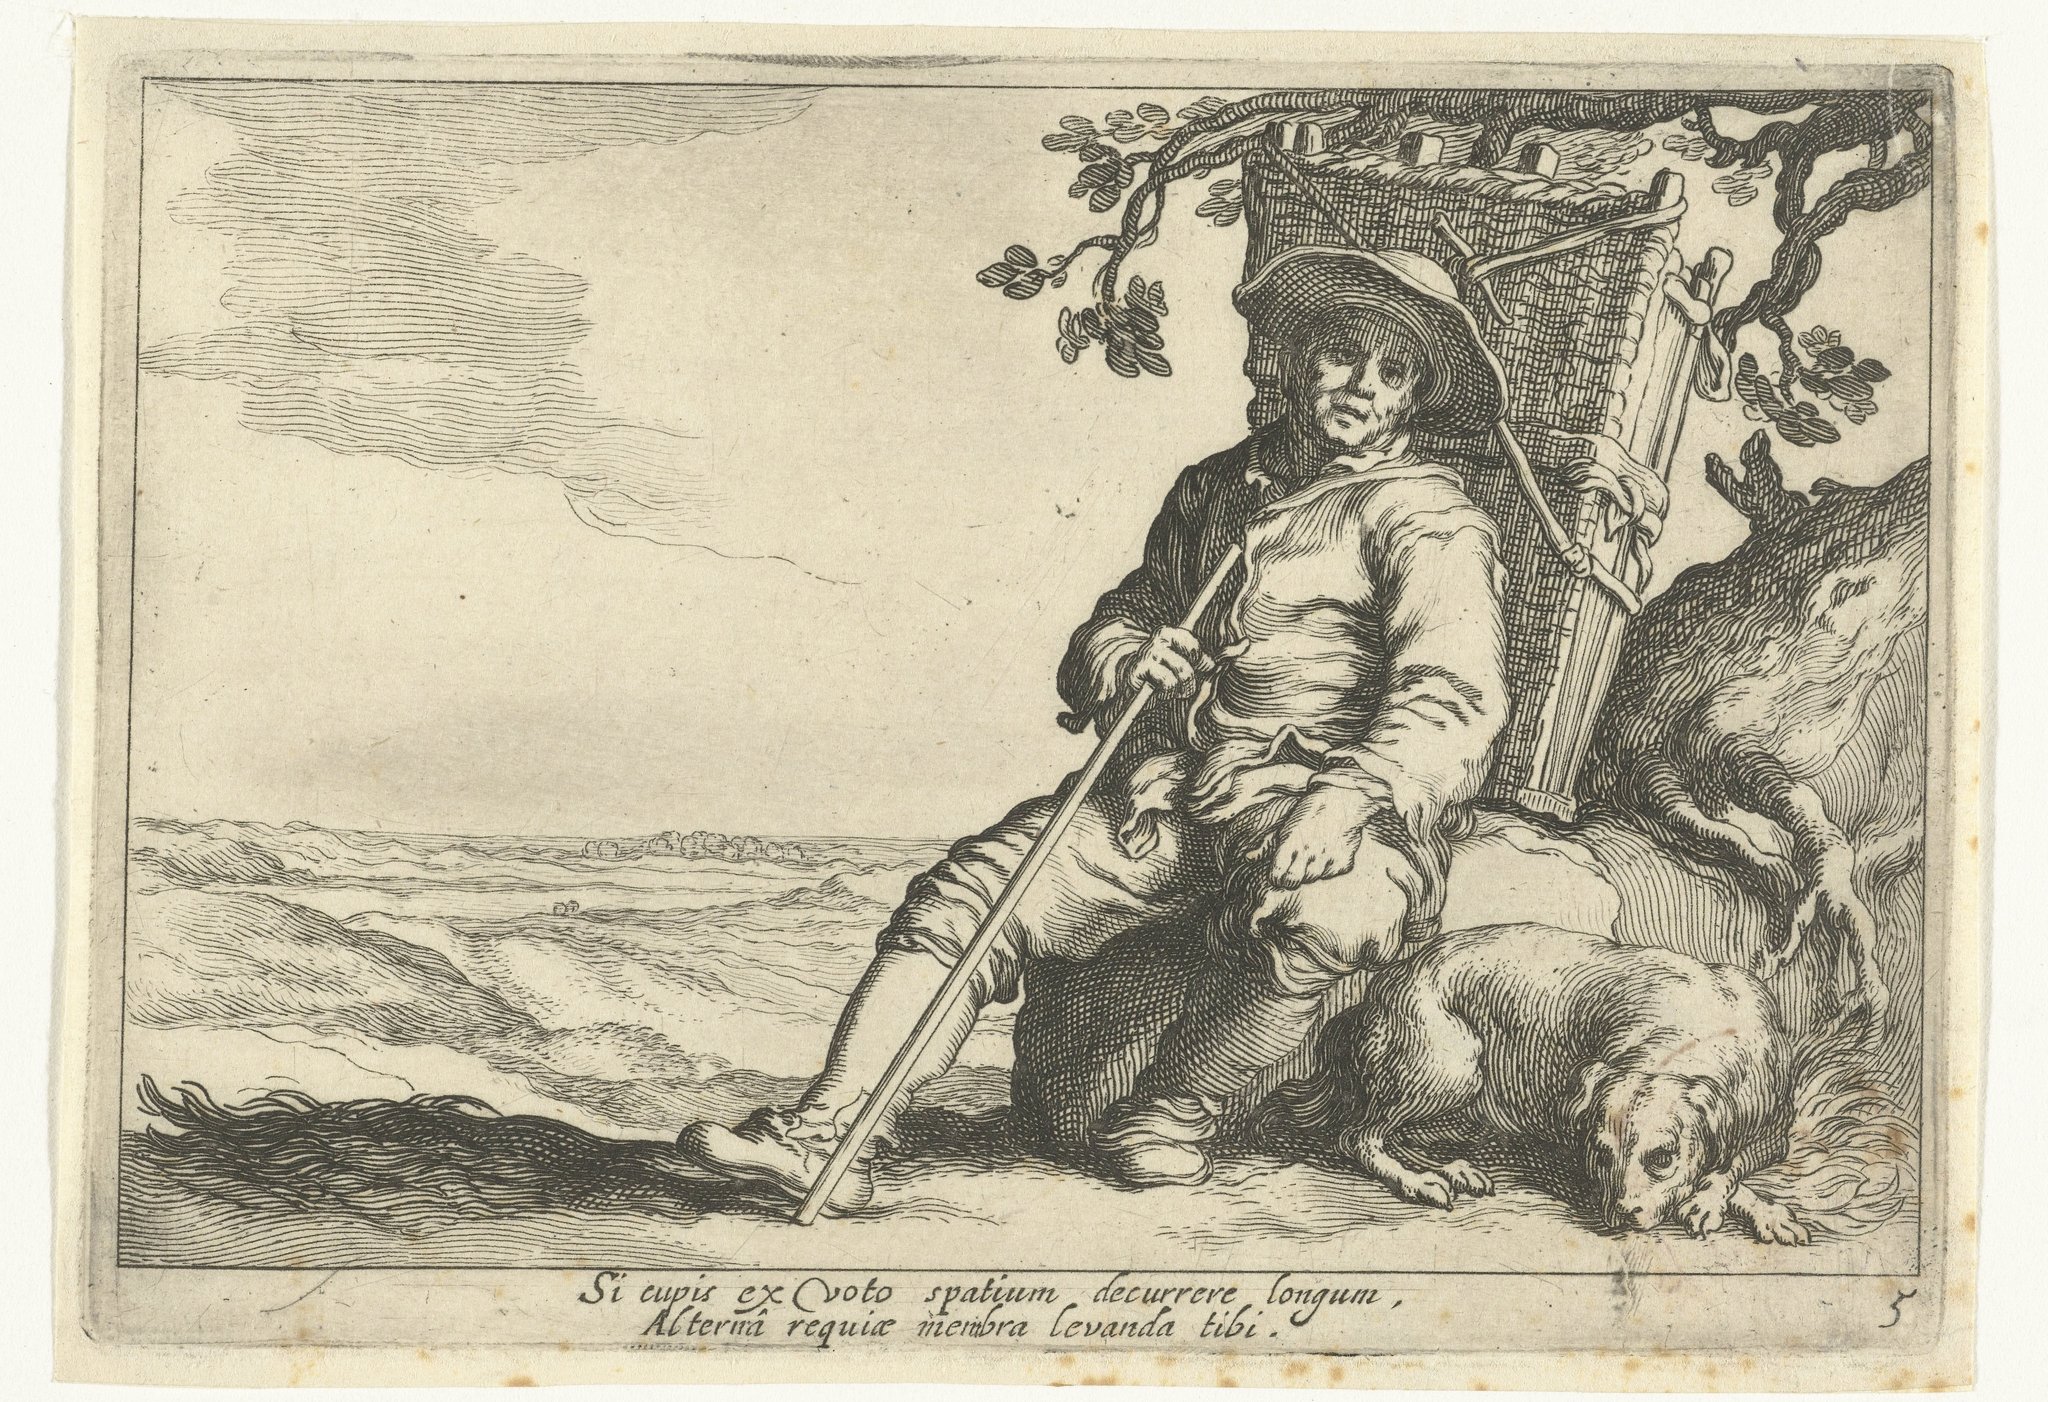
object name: print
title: Een rustende marskramer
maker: cornelis bloemaert (ii)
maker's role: draughtsman, print maker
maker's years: 1603-1692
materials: paper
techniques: engraving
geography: utrecht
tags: wandering or travelling merchant, pastorals, arcadian scenes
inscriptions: collector's mark: Lugt 240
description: Een man zit tegen een boom geleund. Naast hem een liggende hond. Met tweeregelig Latijns onderschrift.